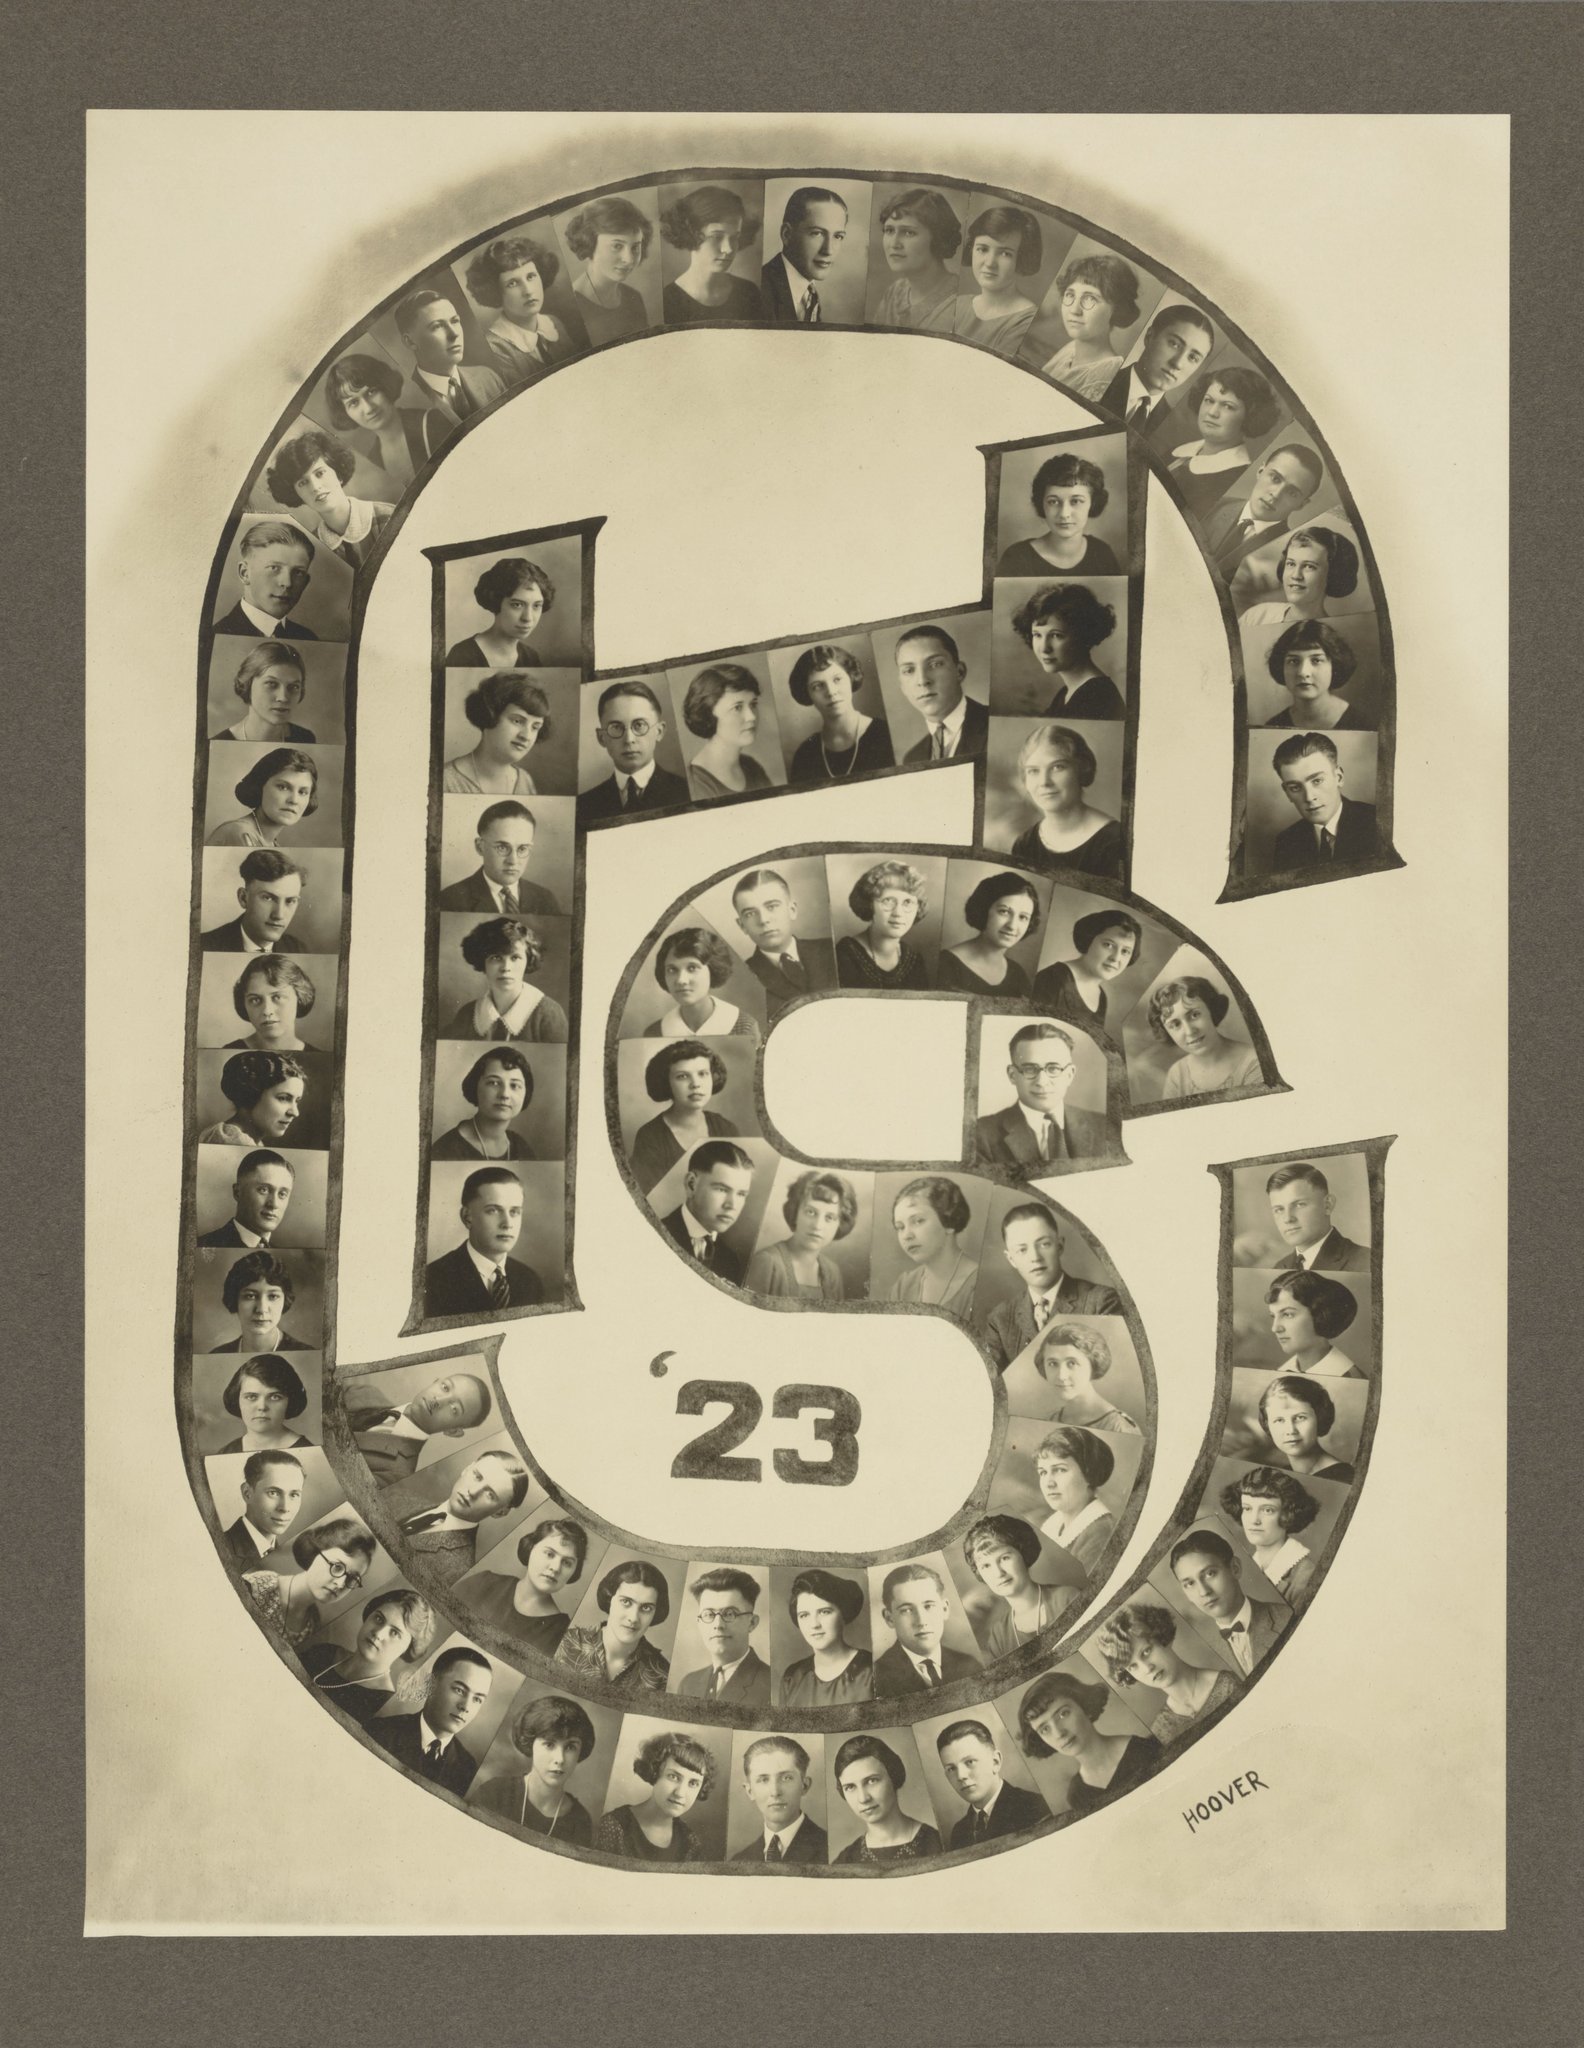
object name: photograph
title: Fotoreproductie van fotografische portretten van onbekende studenten van Hoover High School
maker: Anonymous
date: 1923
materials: paper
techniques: gelatin silver print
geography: united states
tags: historical persons not known by name - bb - woman, secondary education, historical persons not known by name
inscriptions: inscription: ‘Owen/ Romberg [?]’, label: ‘To have me properly/ Framed return to/ HOOVER’S Studio’